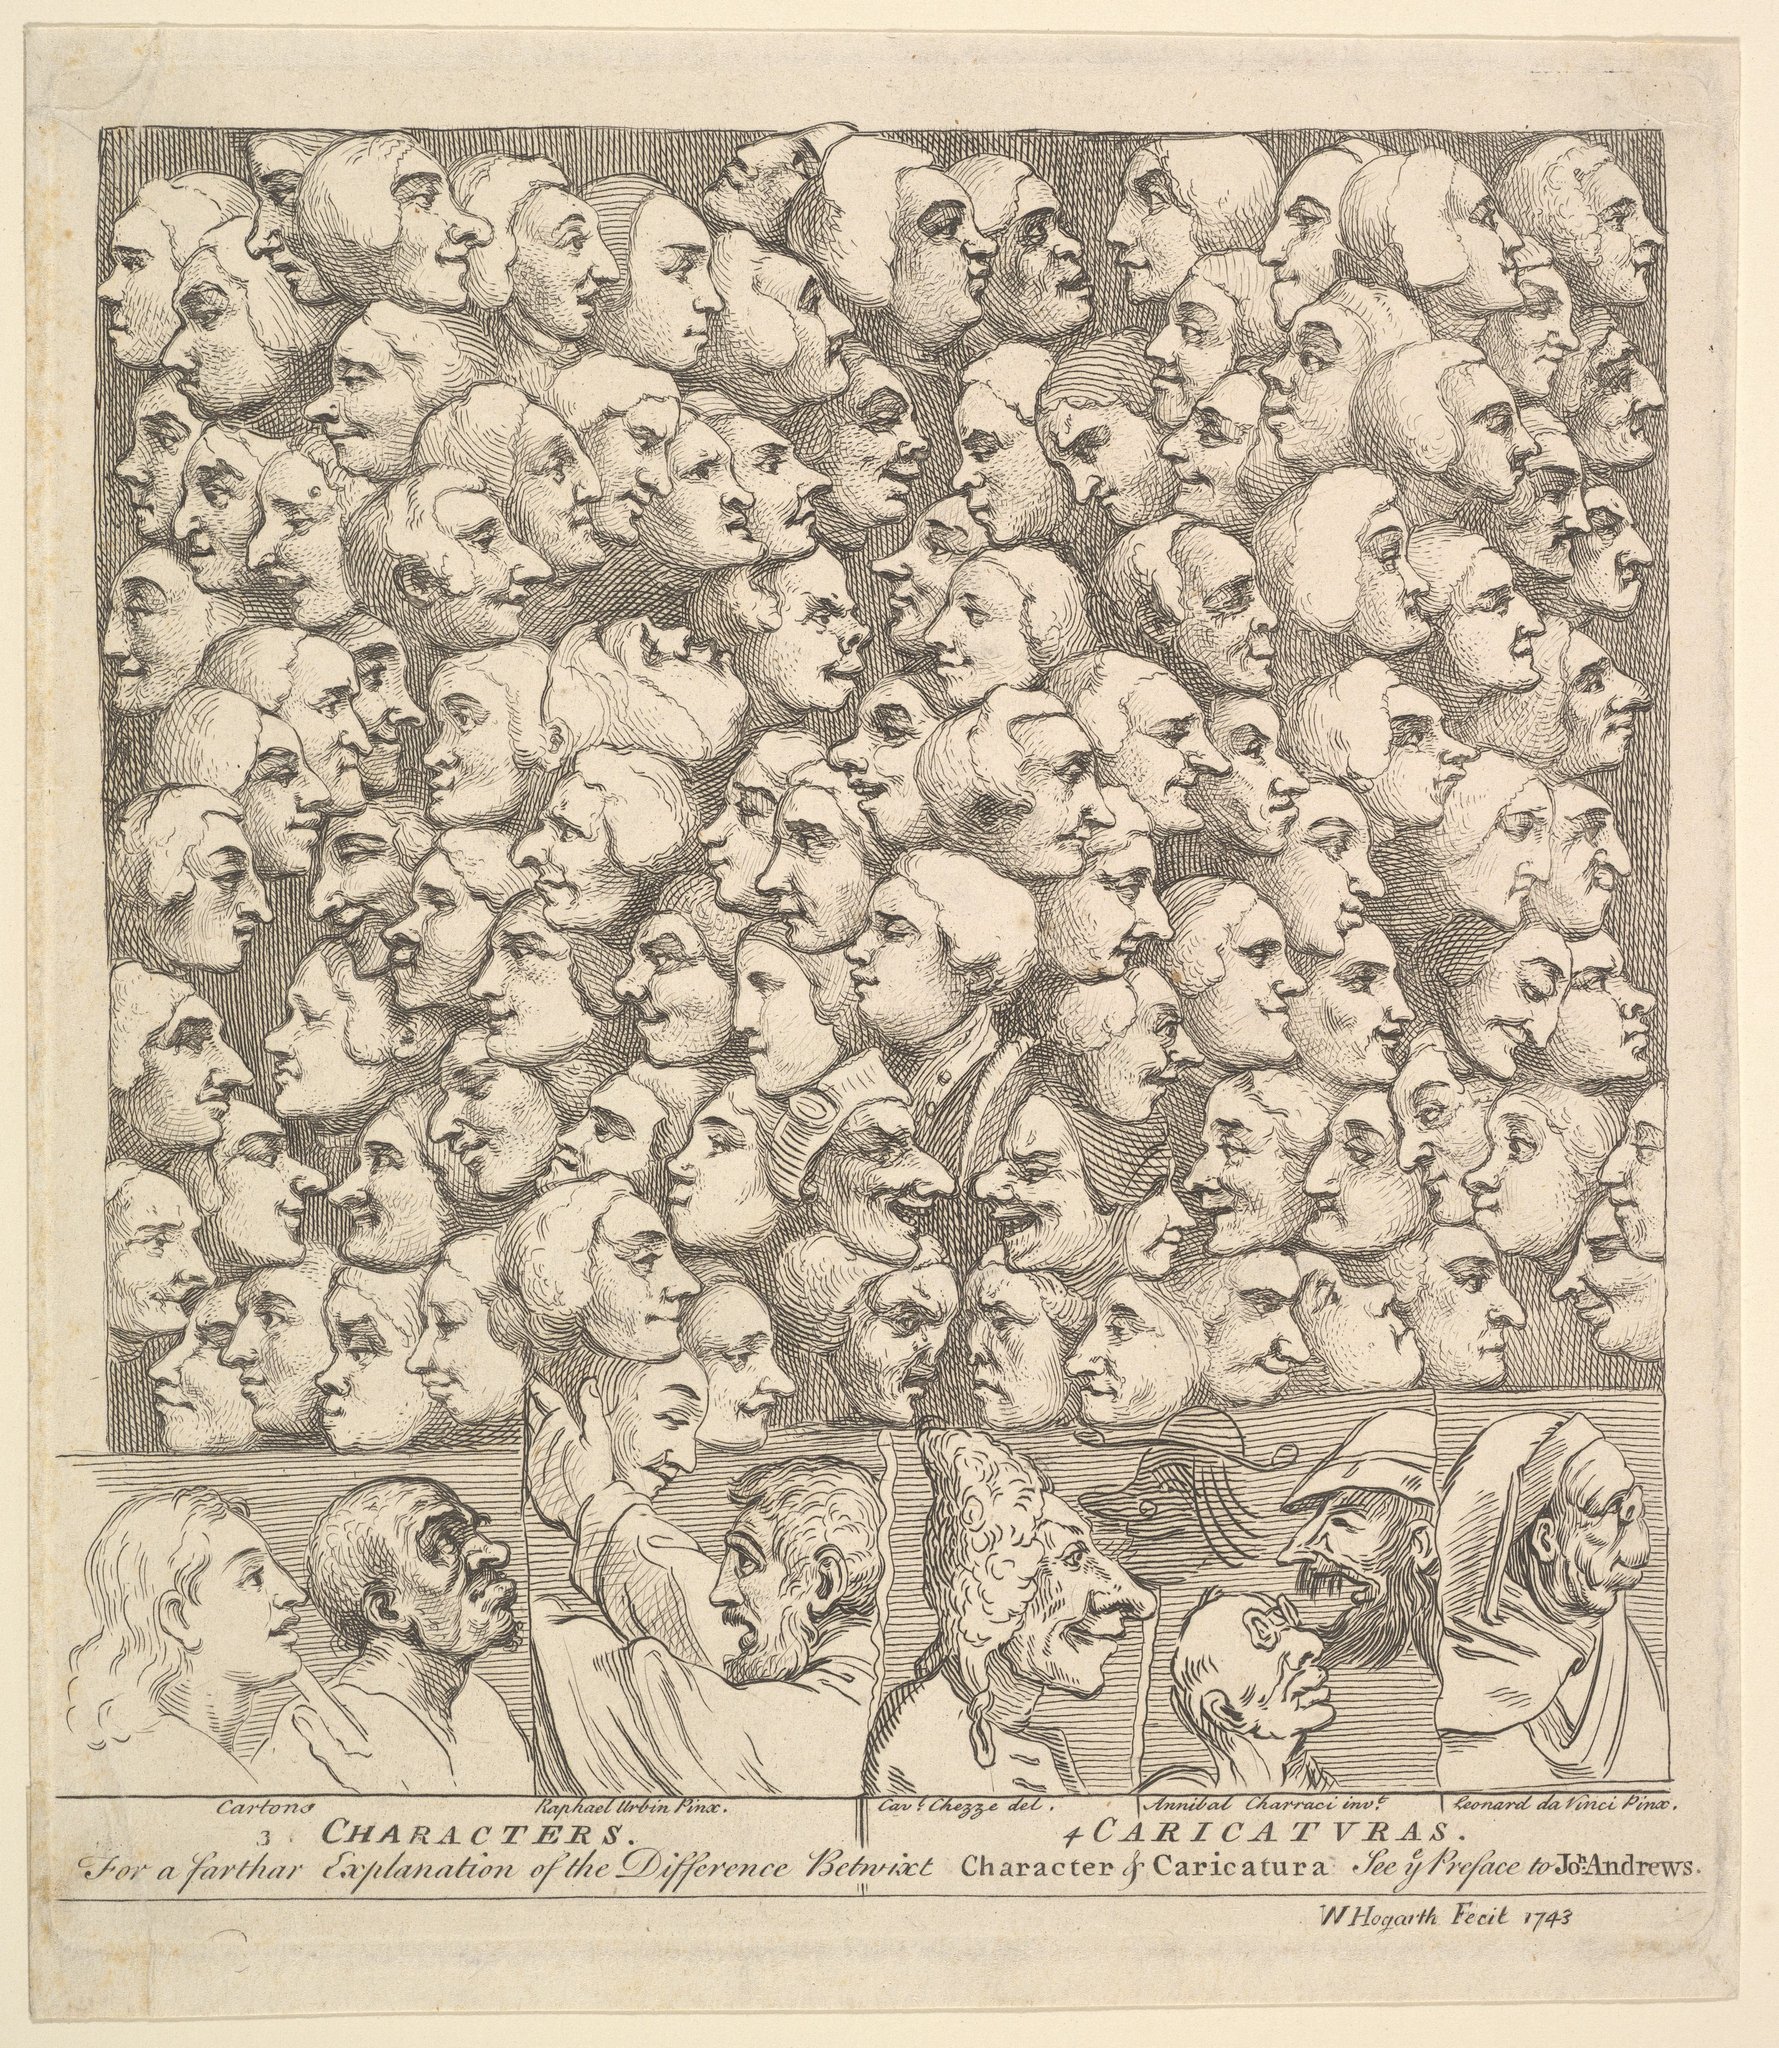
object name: print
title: Characters and Caricaturas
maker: william hogarth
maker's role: artist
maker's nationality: british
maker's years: 1697-1764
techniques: etching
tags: faces,profiles